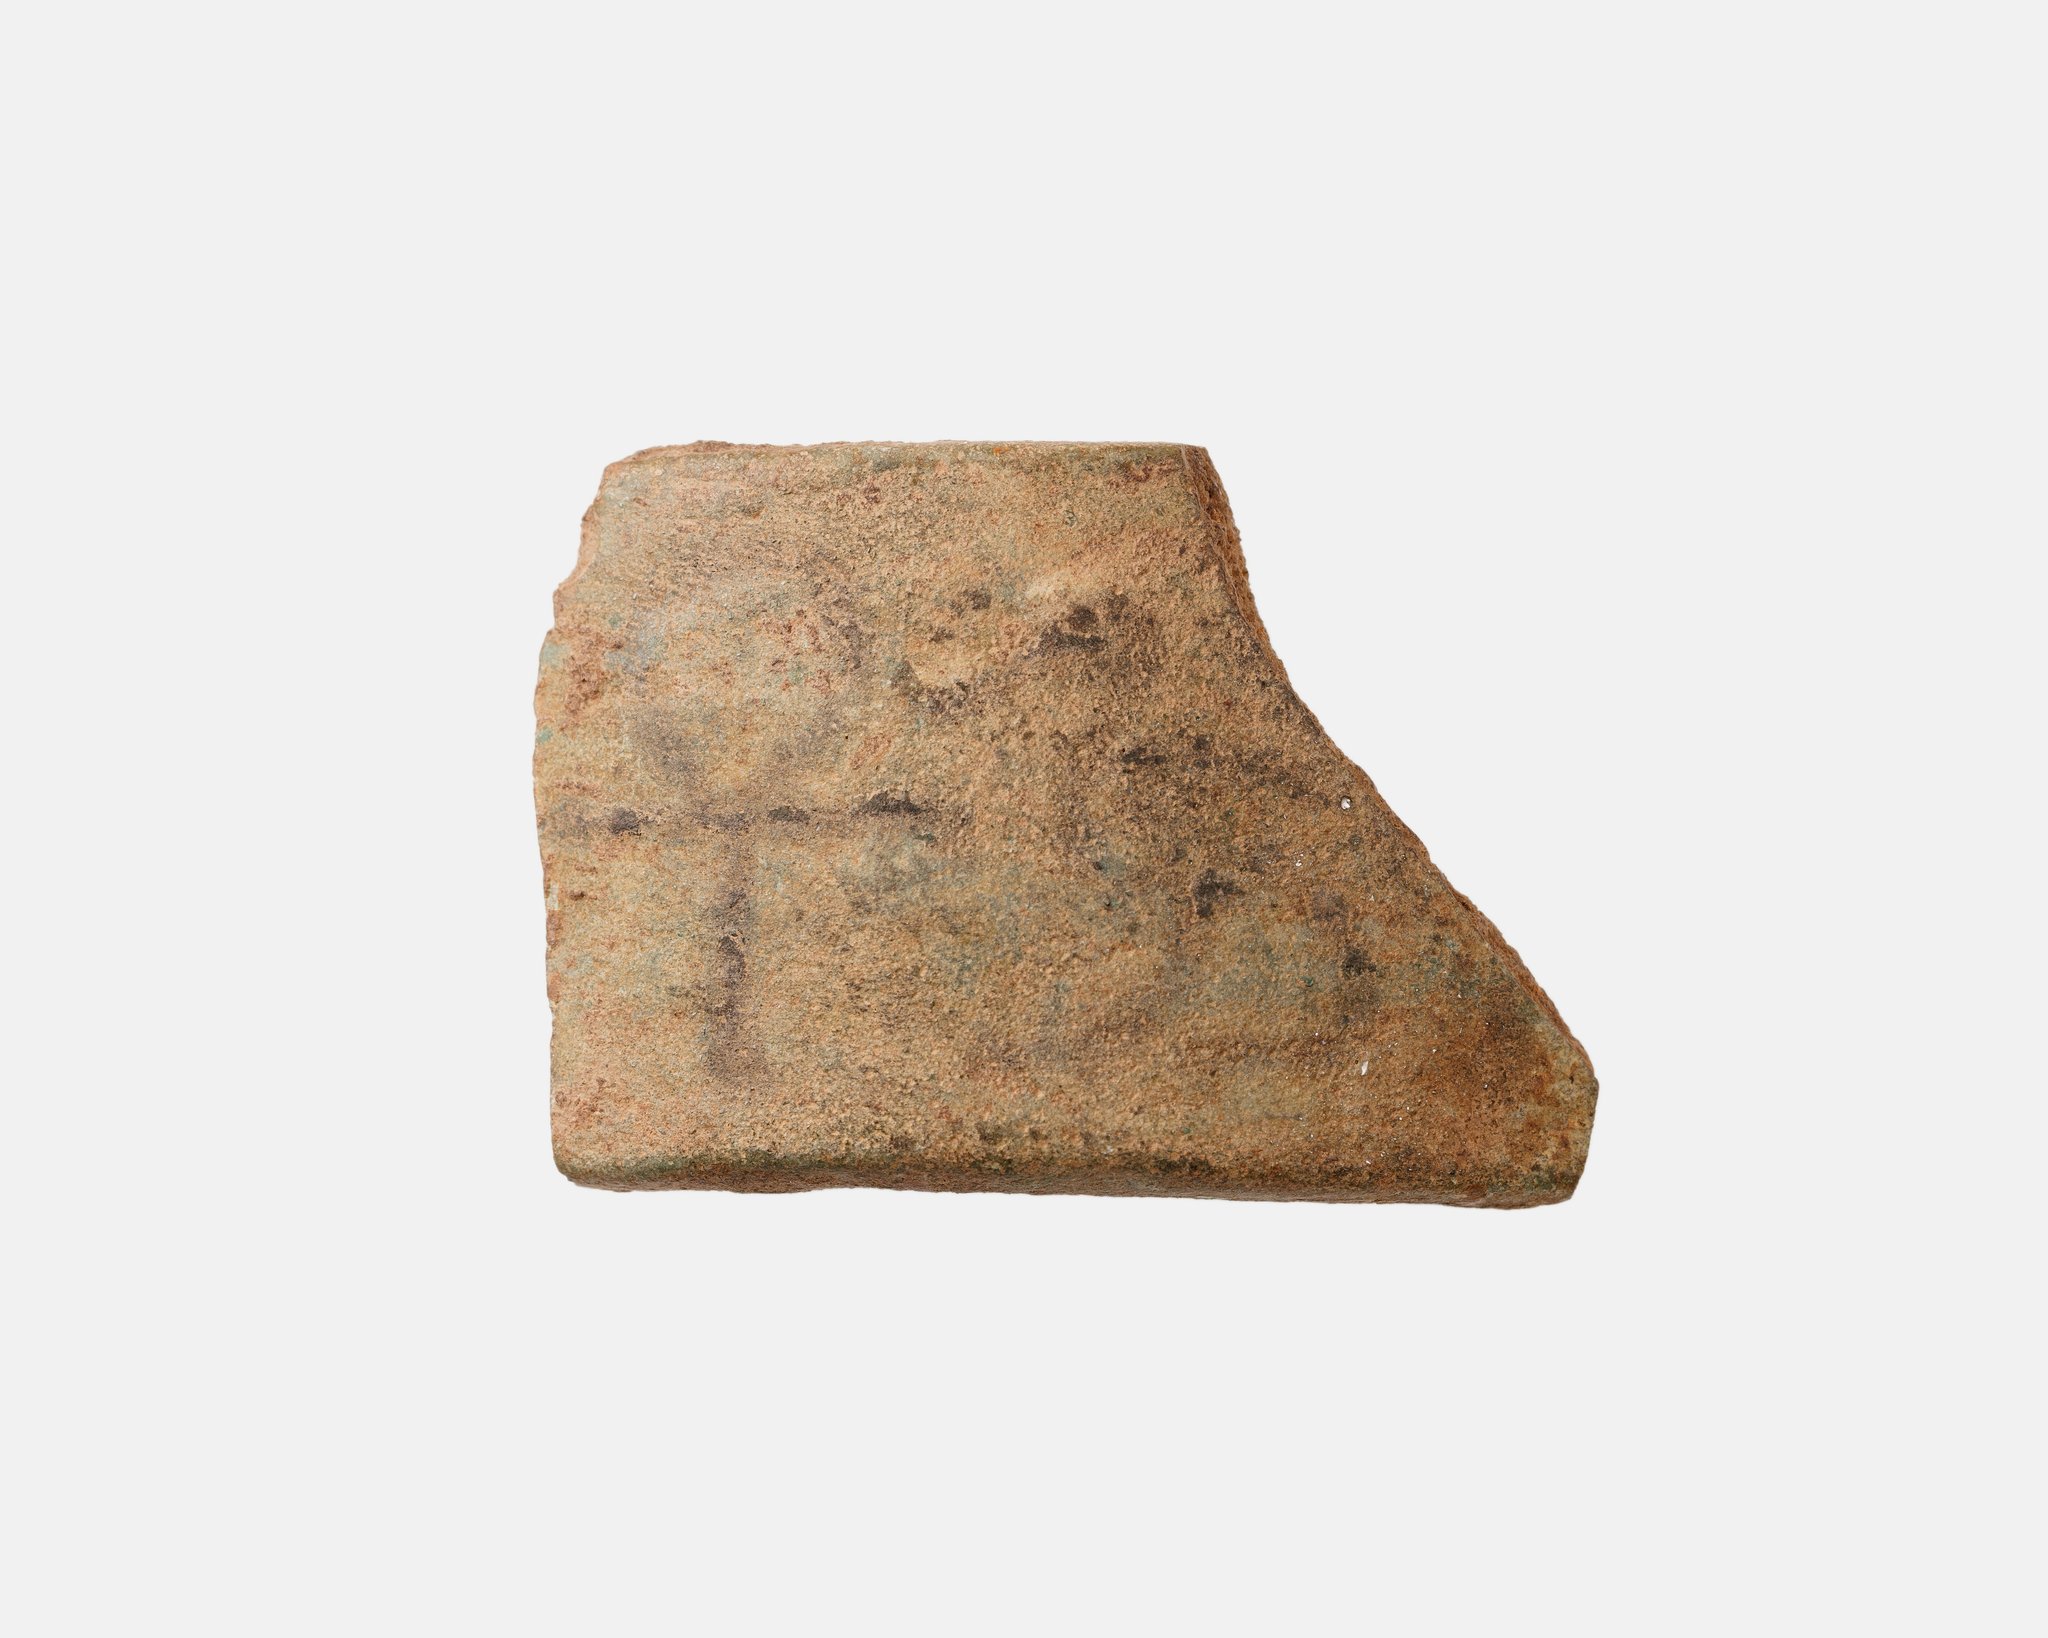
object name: votive bracelet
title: Fragment of a votive bracelet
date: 1295-1070 BCE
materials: faience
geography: egypt